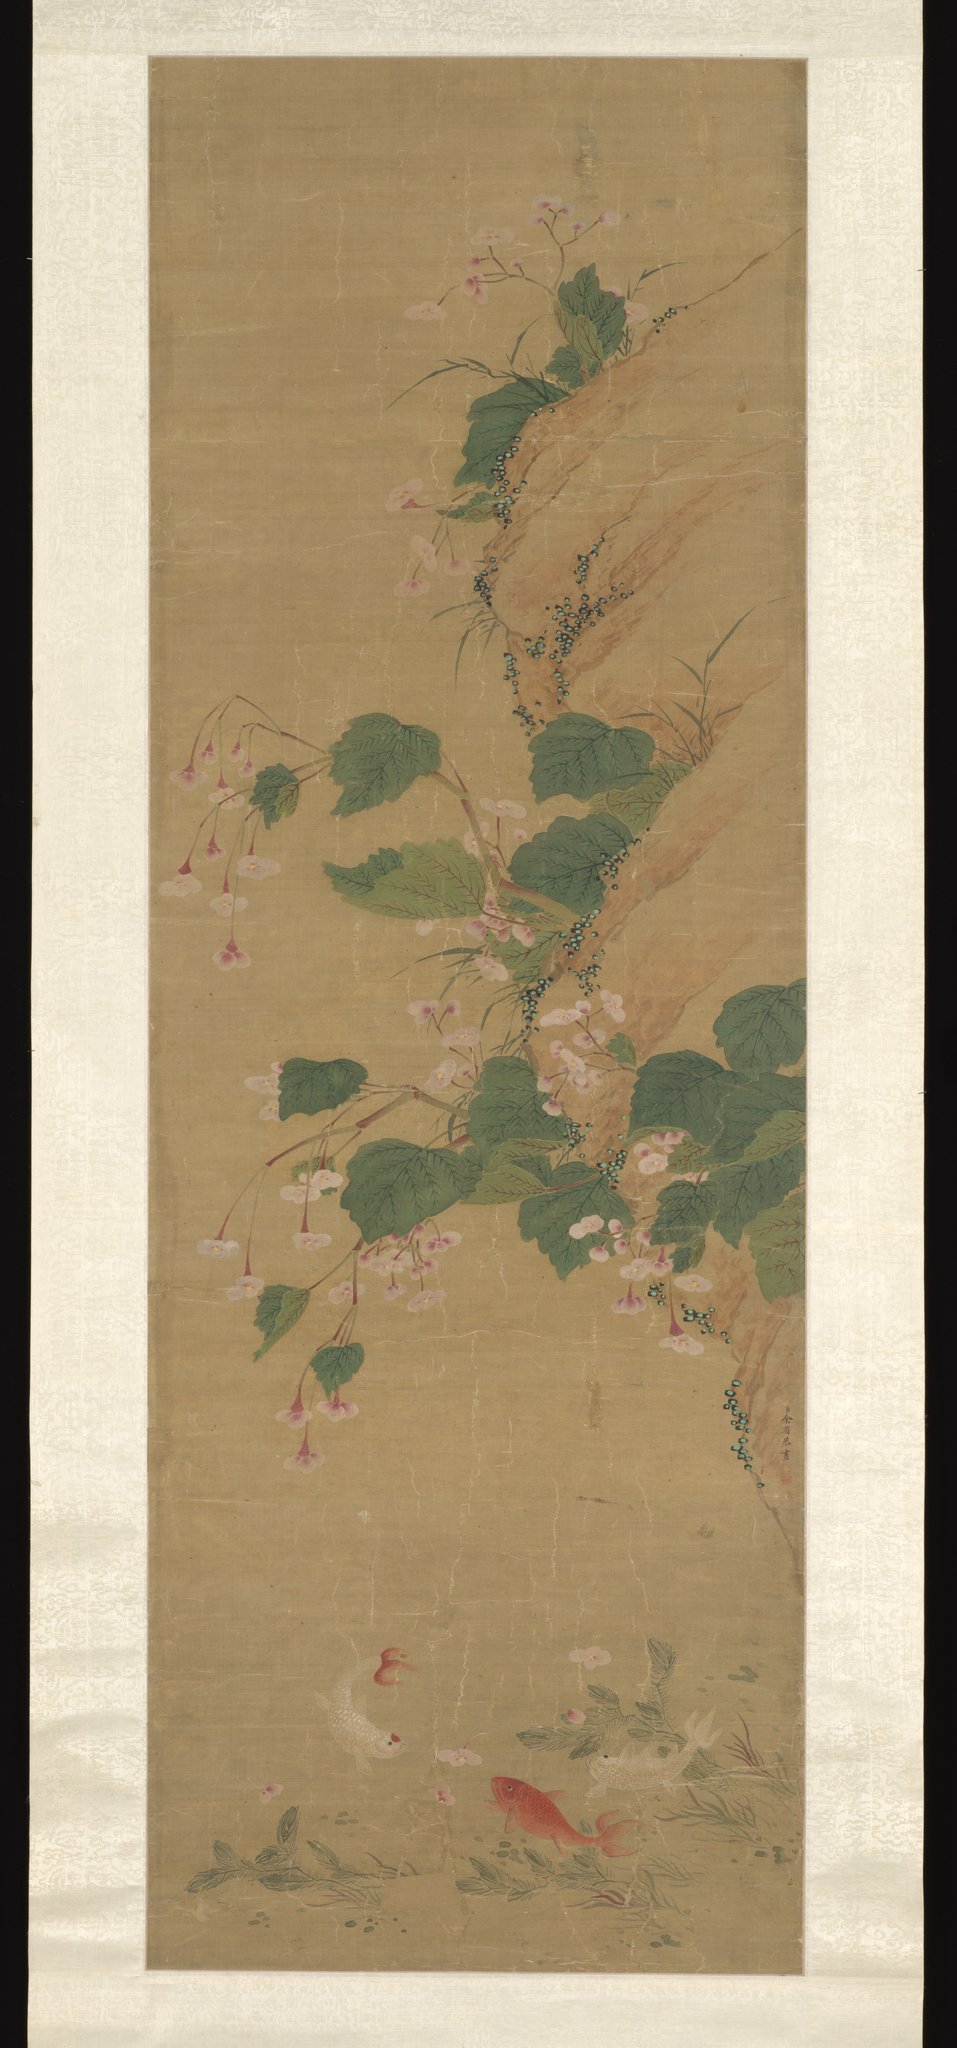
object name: hanging scroll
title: Flowering Branches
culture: chinese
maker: yu xing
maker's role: artist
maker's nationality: chinese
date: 1736-1795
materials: ink, silk